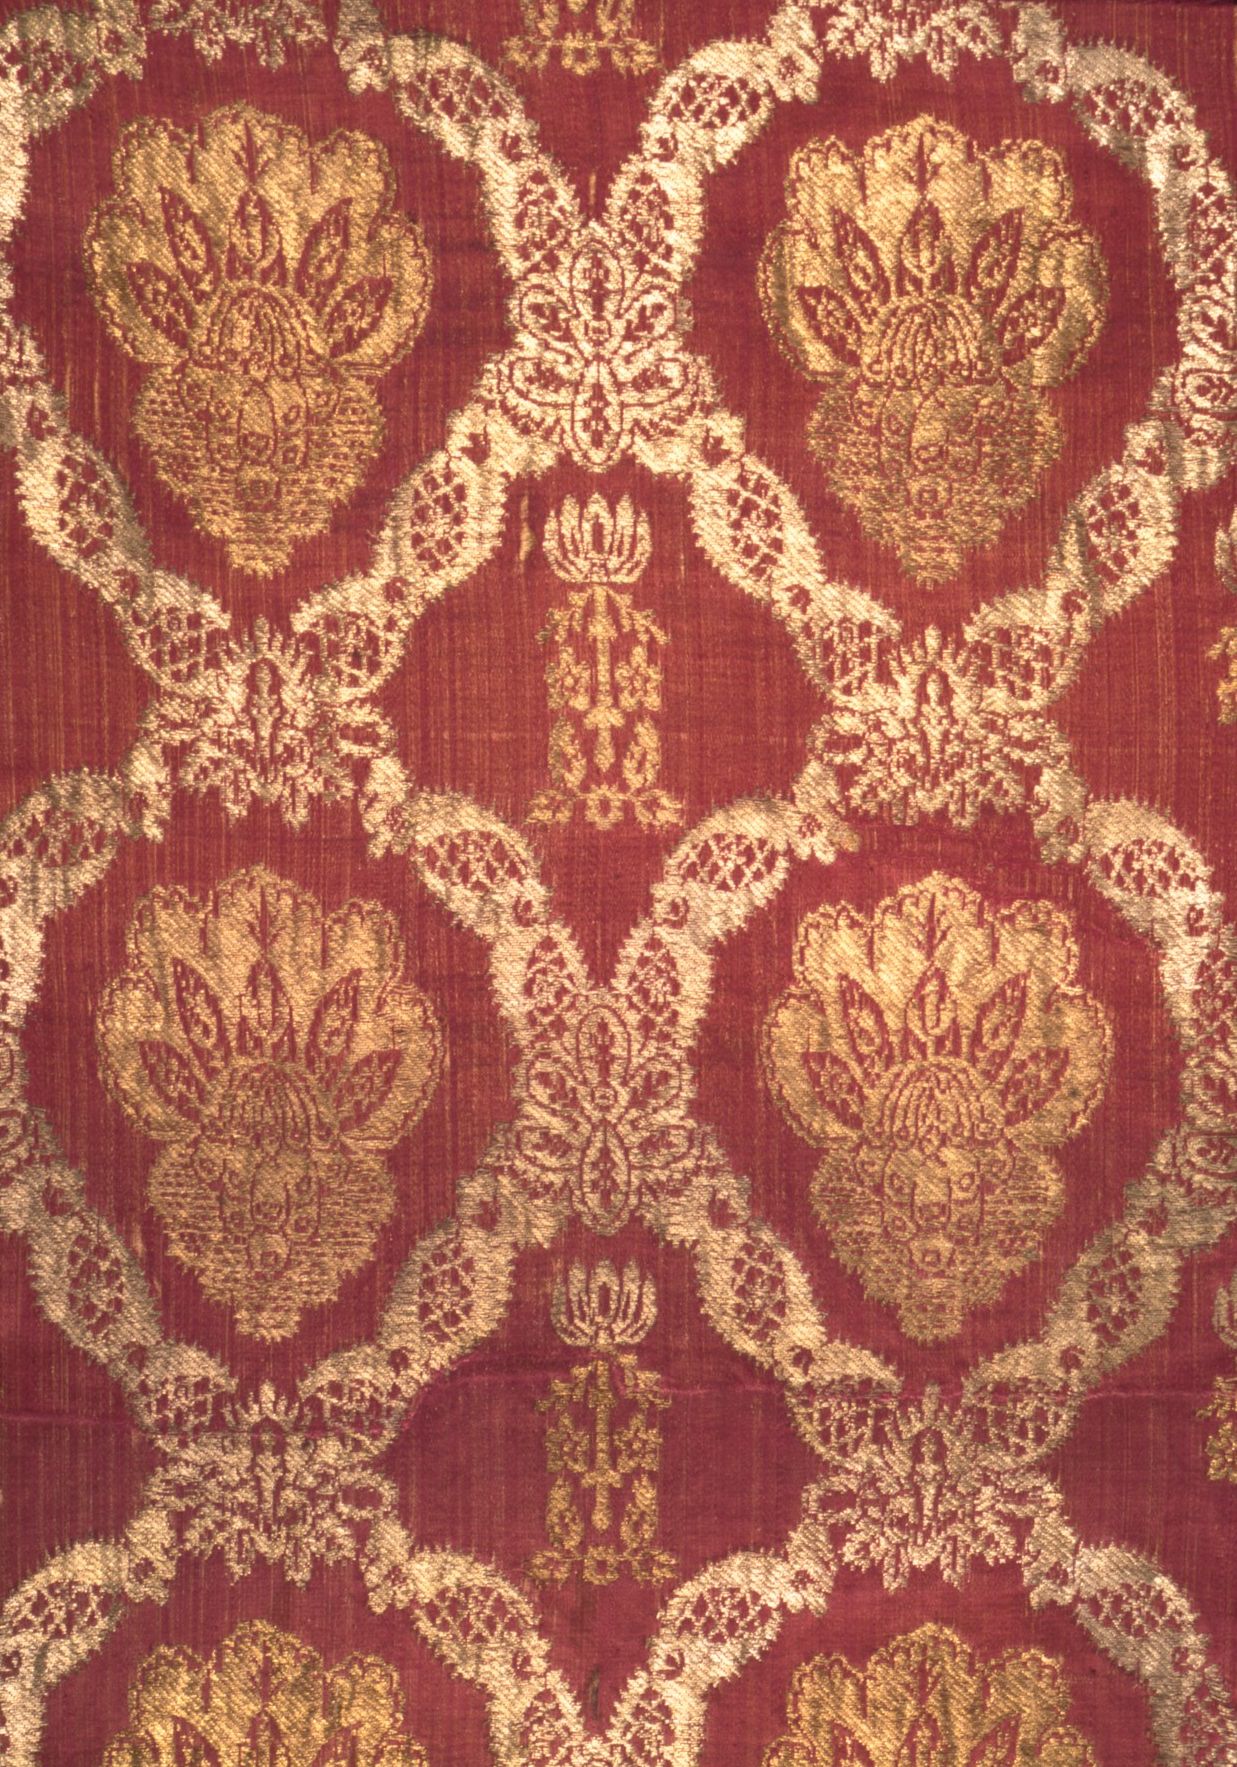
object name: textile panel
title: Panel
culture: french or italian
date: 1701-1733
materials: linen, metal, silk